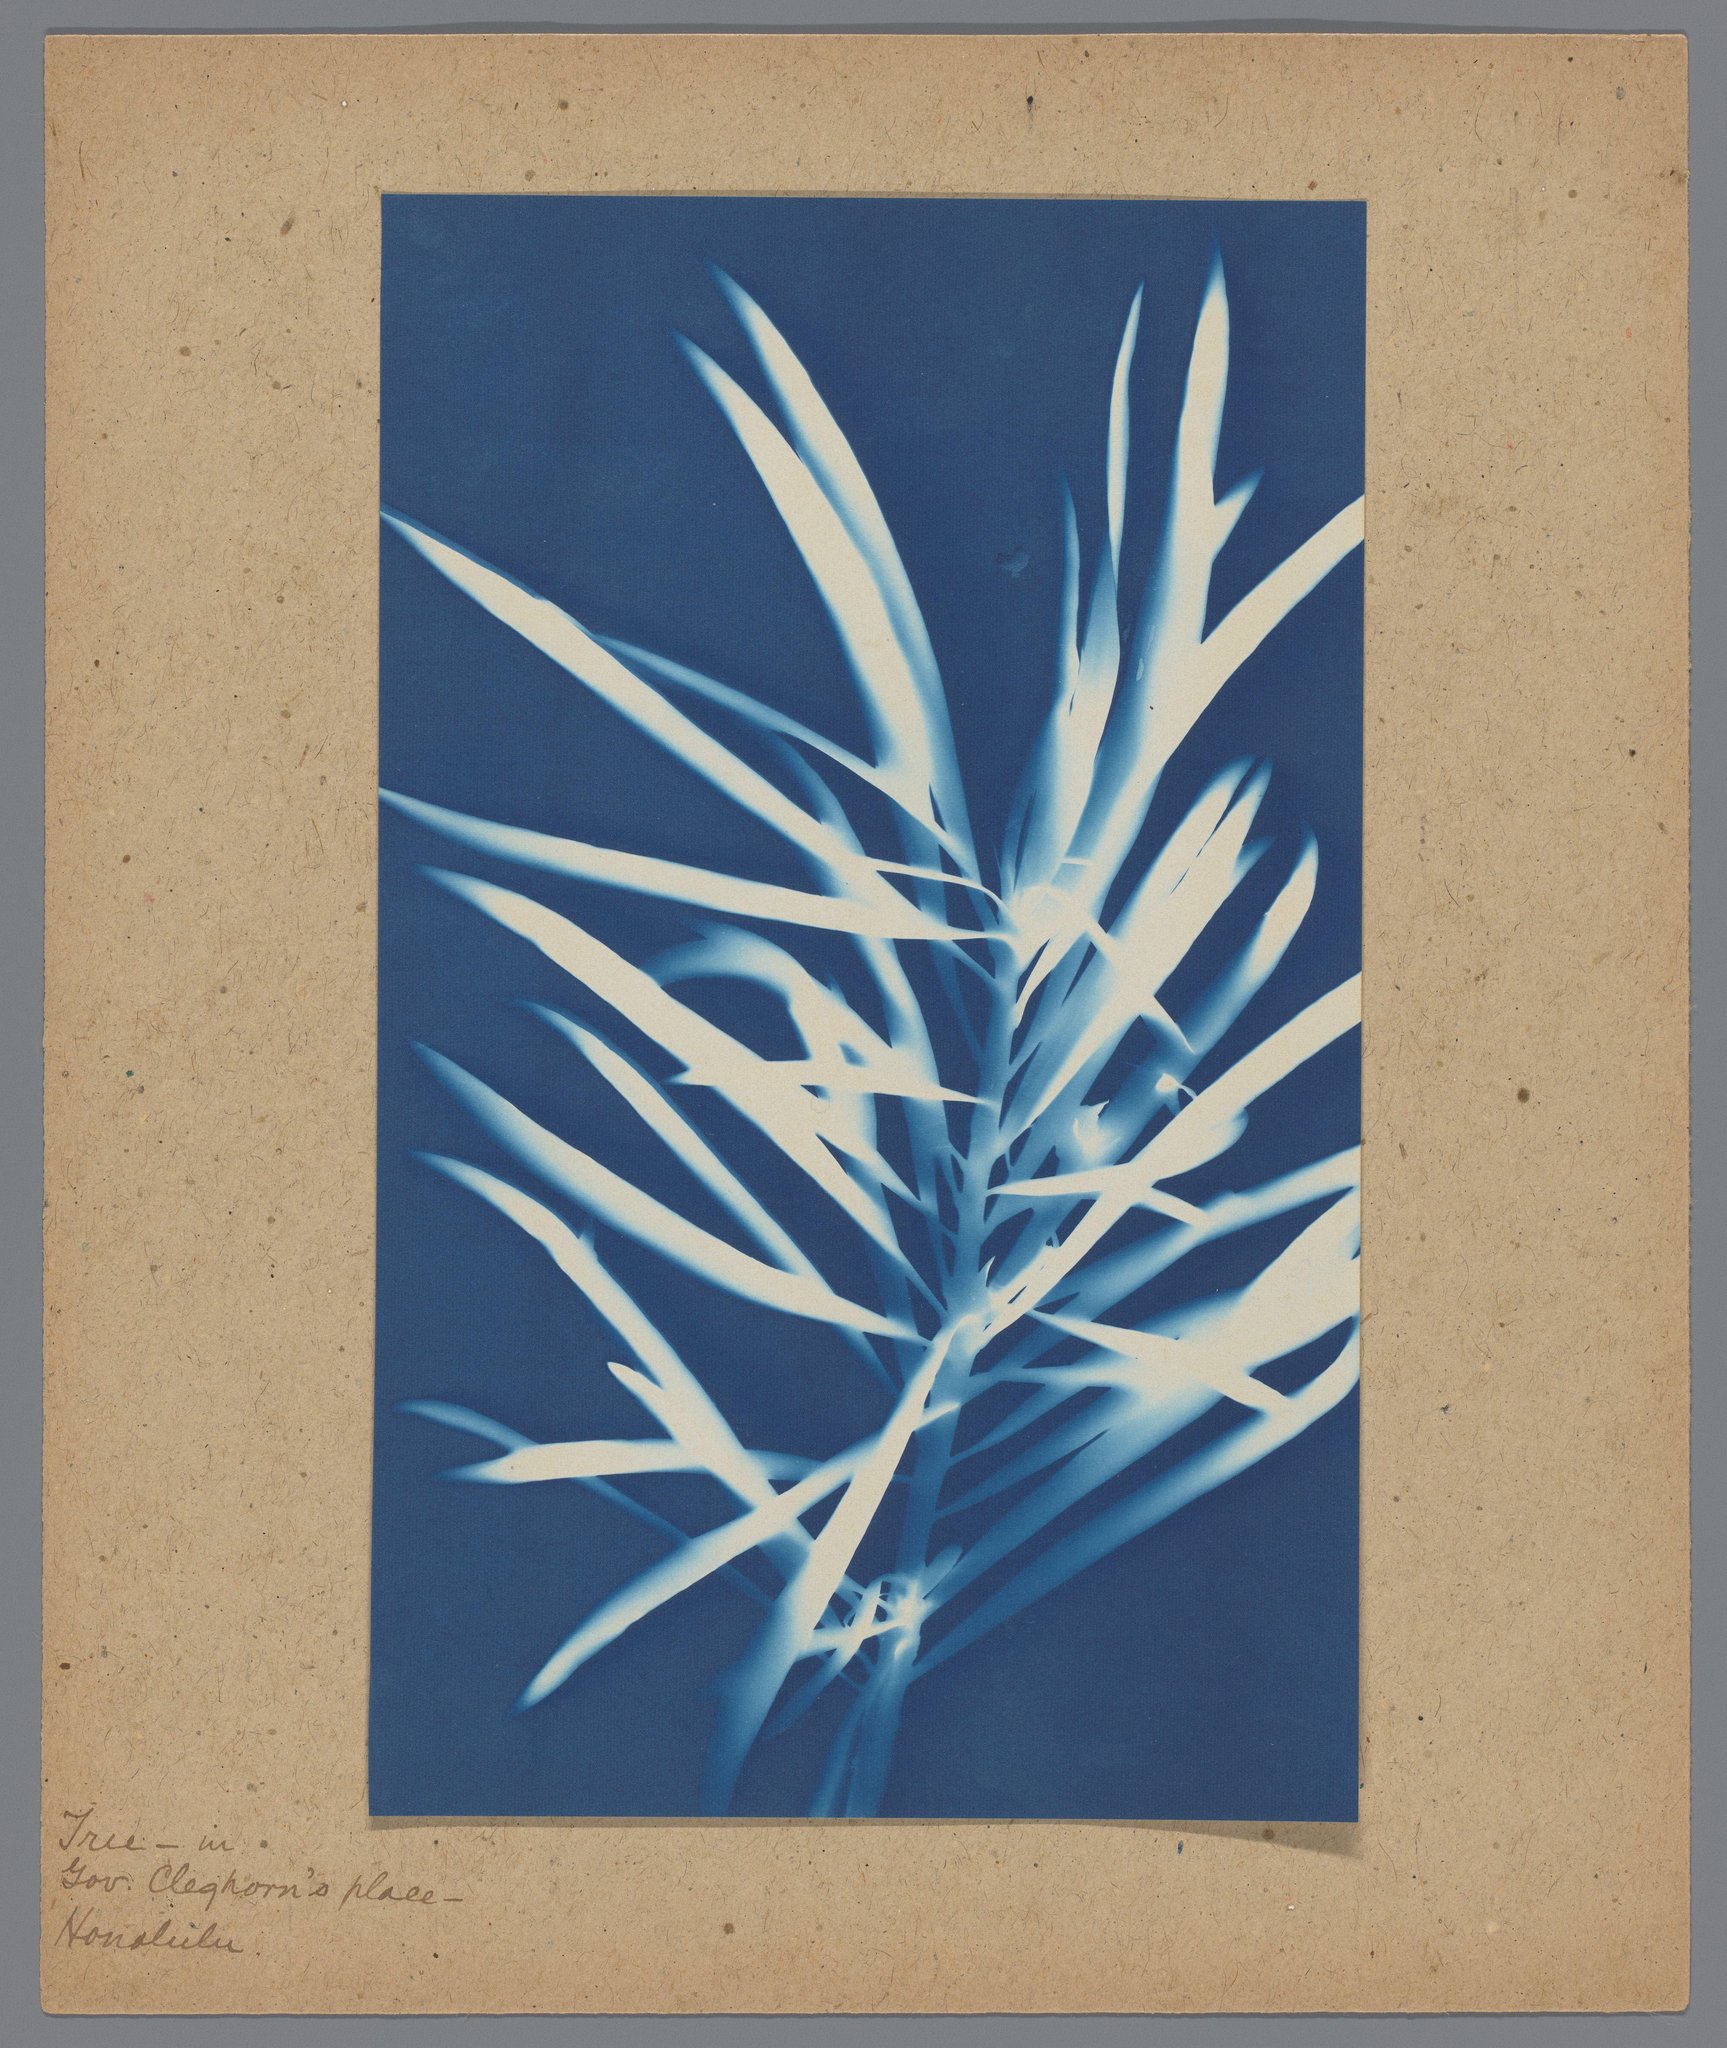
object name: photogram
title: Fotogram van plant, "Tree-in Gov. Cleghorn's Place, Honolulu"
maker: bertha e. jaques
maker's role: fotograaf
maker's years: 1863-1941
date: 1908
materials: cardboard, photographic support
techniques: cyanotype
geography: united states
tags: honolulu